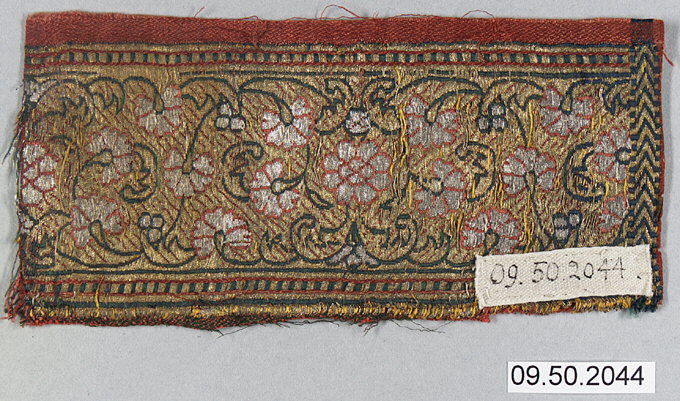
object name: textile fragment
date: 1801-1900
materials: metal thread, silk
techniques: brocade, satin weave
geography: india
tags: flowers